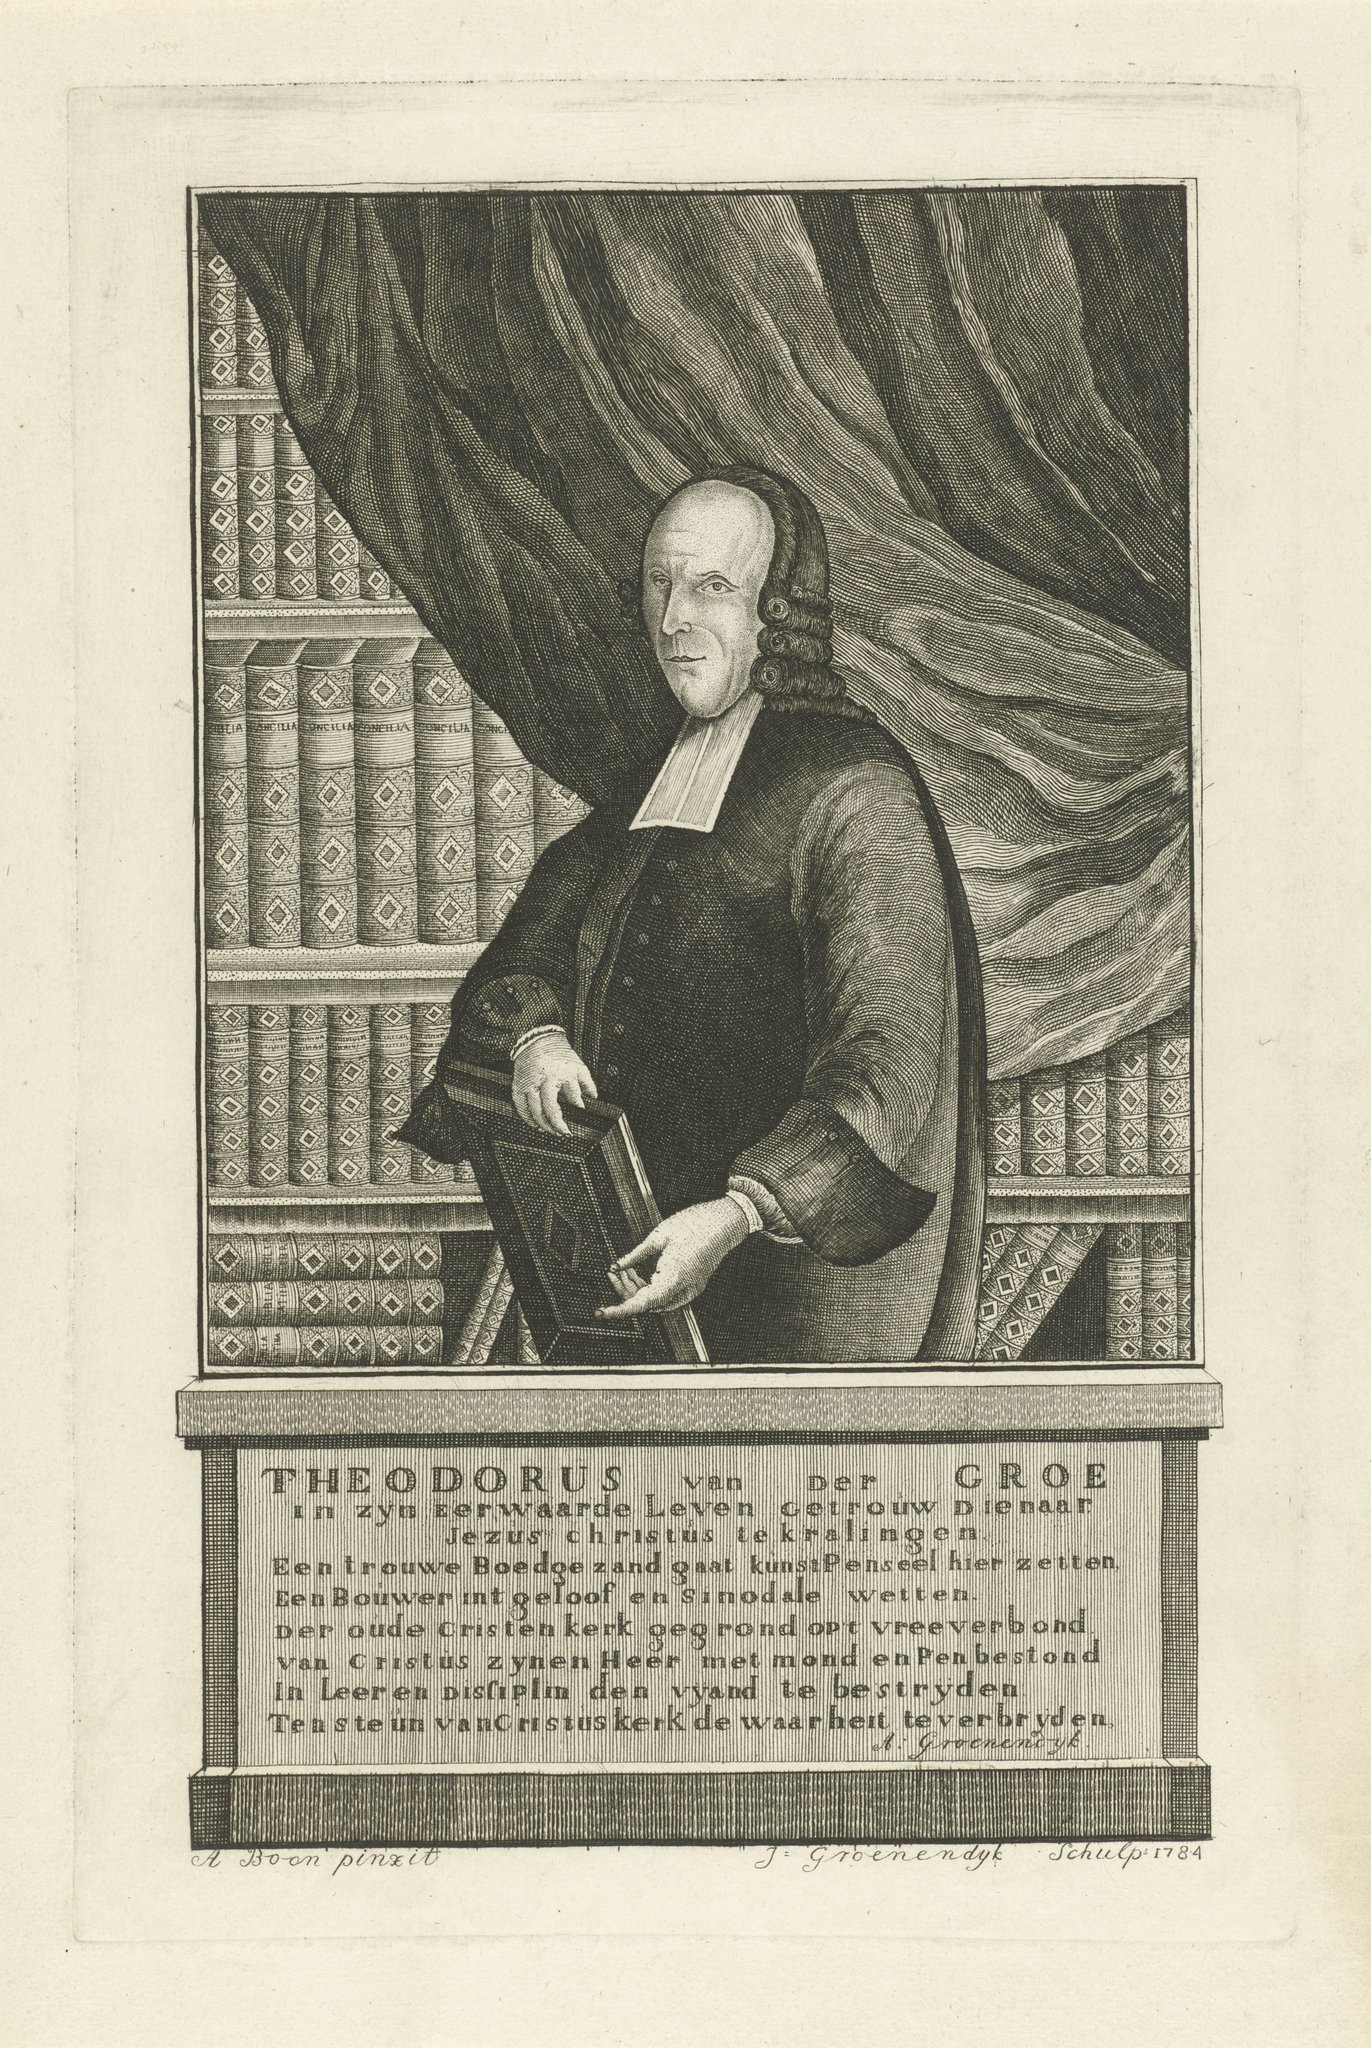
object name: print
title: Portret van Theodorus van der Groe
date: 1784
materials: paper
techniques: engraving, etching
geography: rotterdam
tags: kralingen, predikant, theodorus van der groe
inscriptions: collector's mark: Lugt 2228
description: Portret van de predikant en theoloog Theodorus van der Groe in zijn studeerkamer. De prent heeft een Nederlands gedicht in nagedachtenis van Theodorus van der Groe.